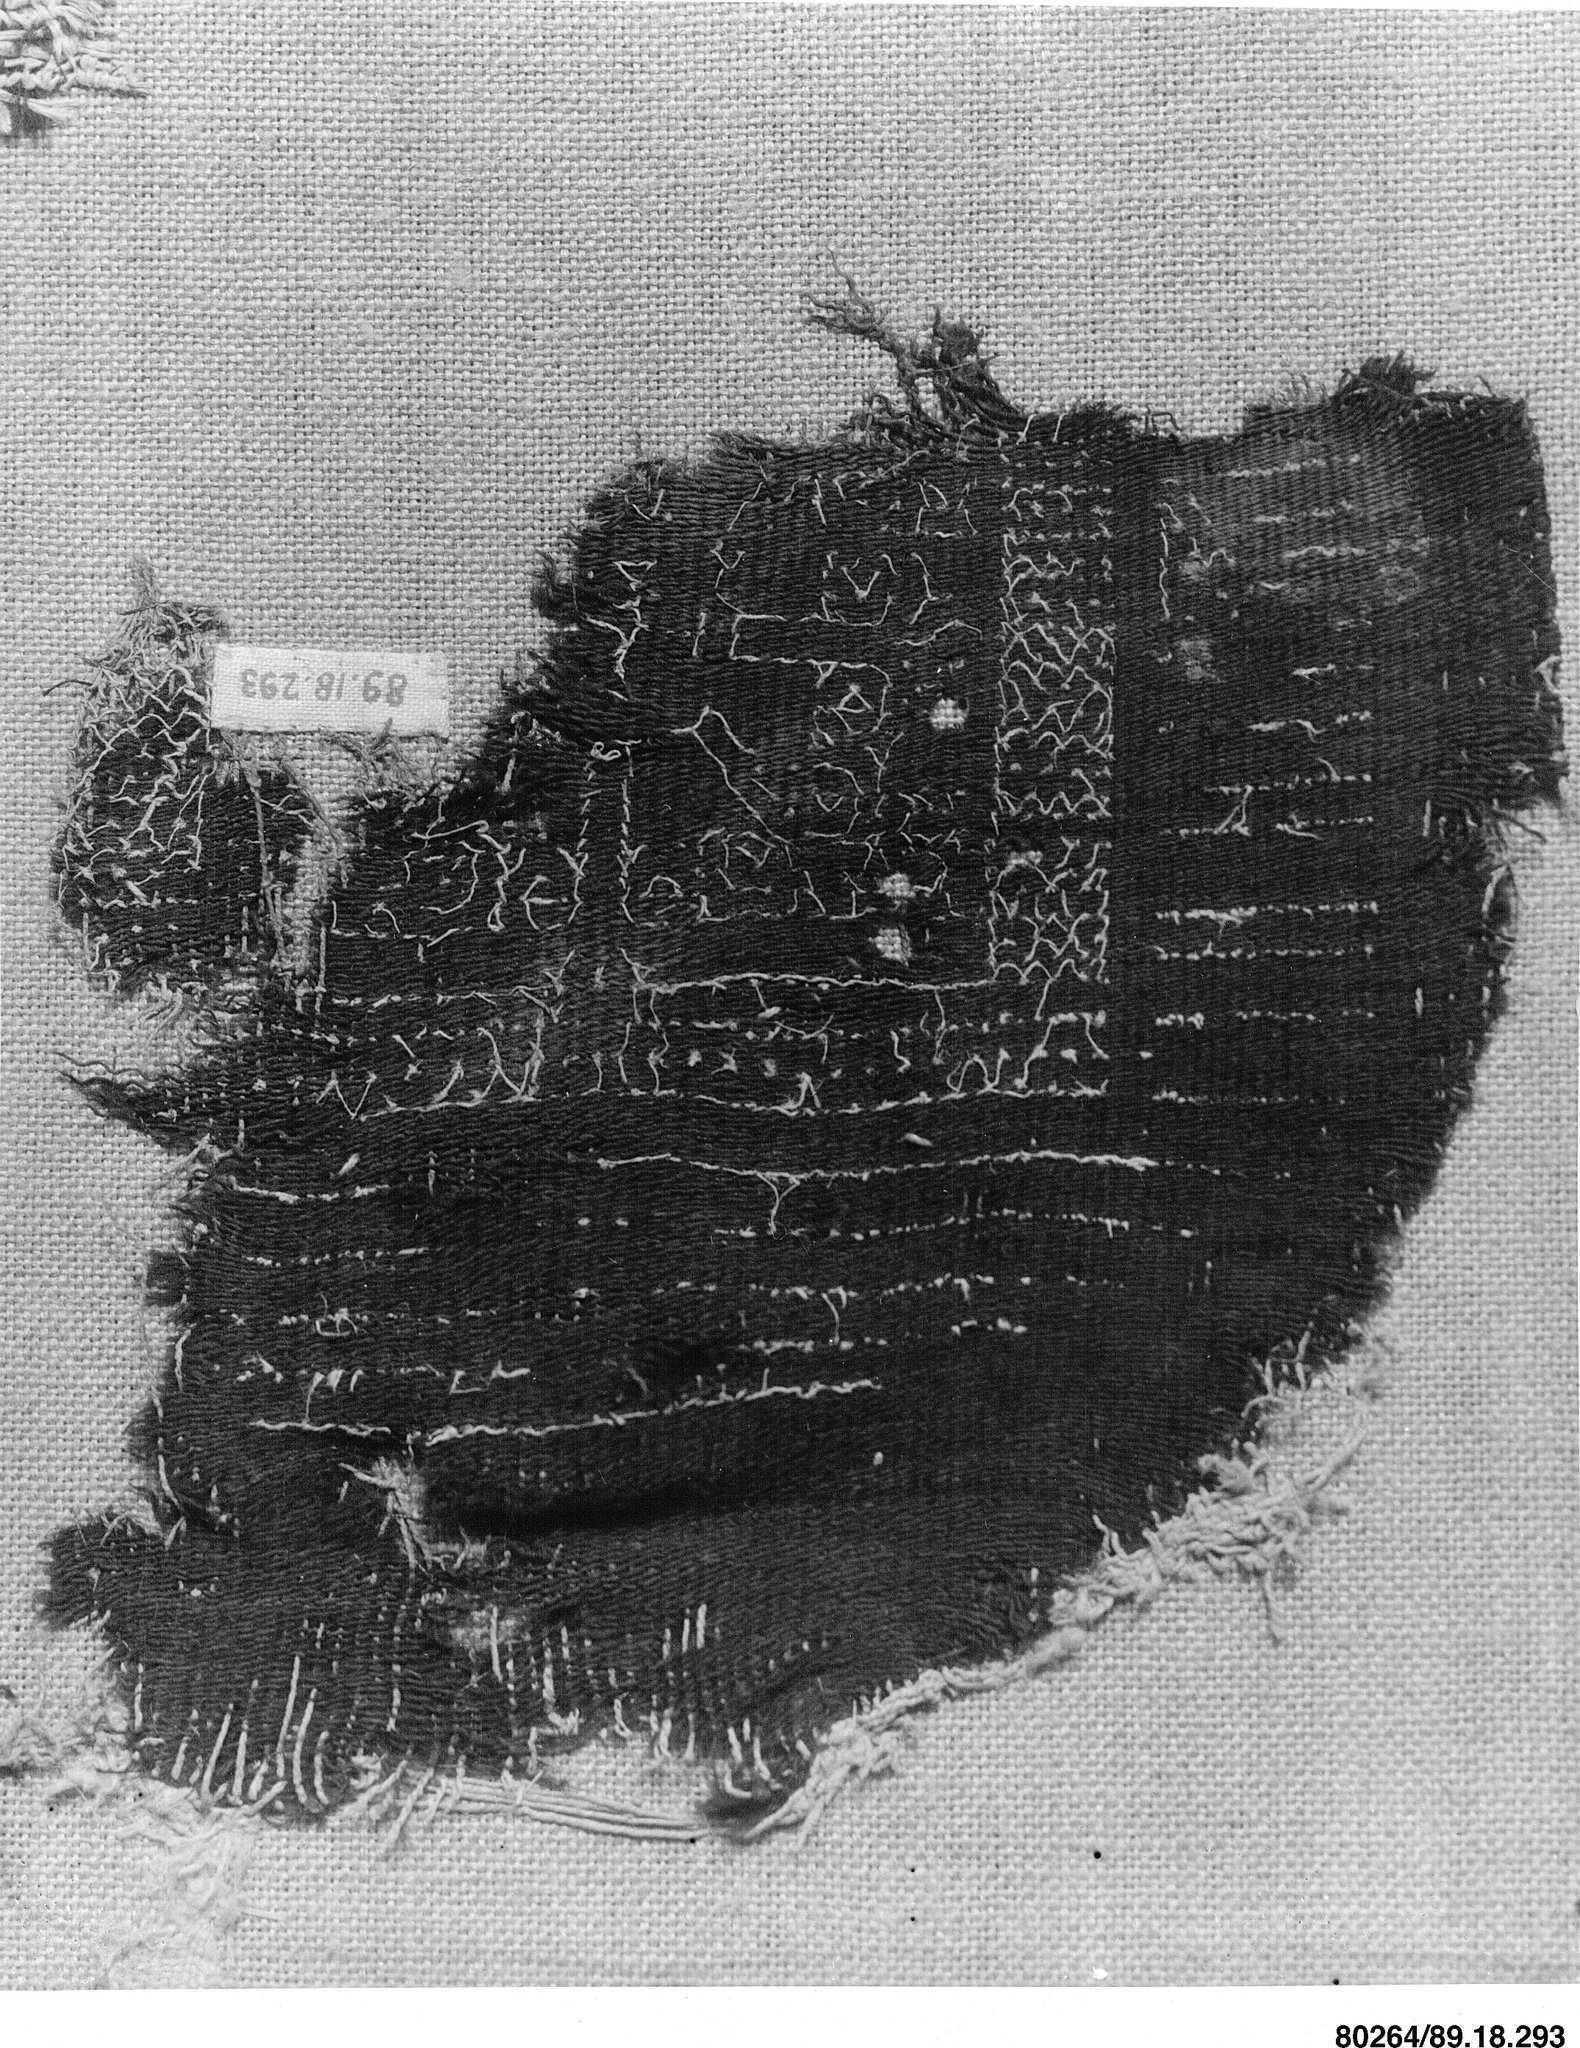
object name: textile fragment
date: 201-400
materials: linen, wool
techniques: weave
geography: egypt